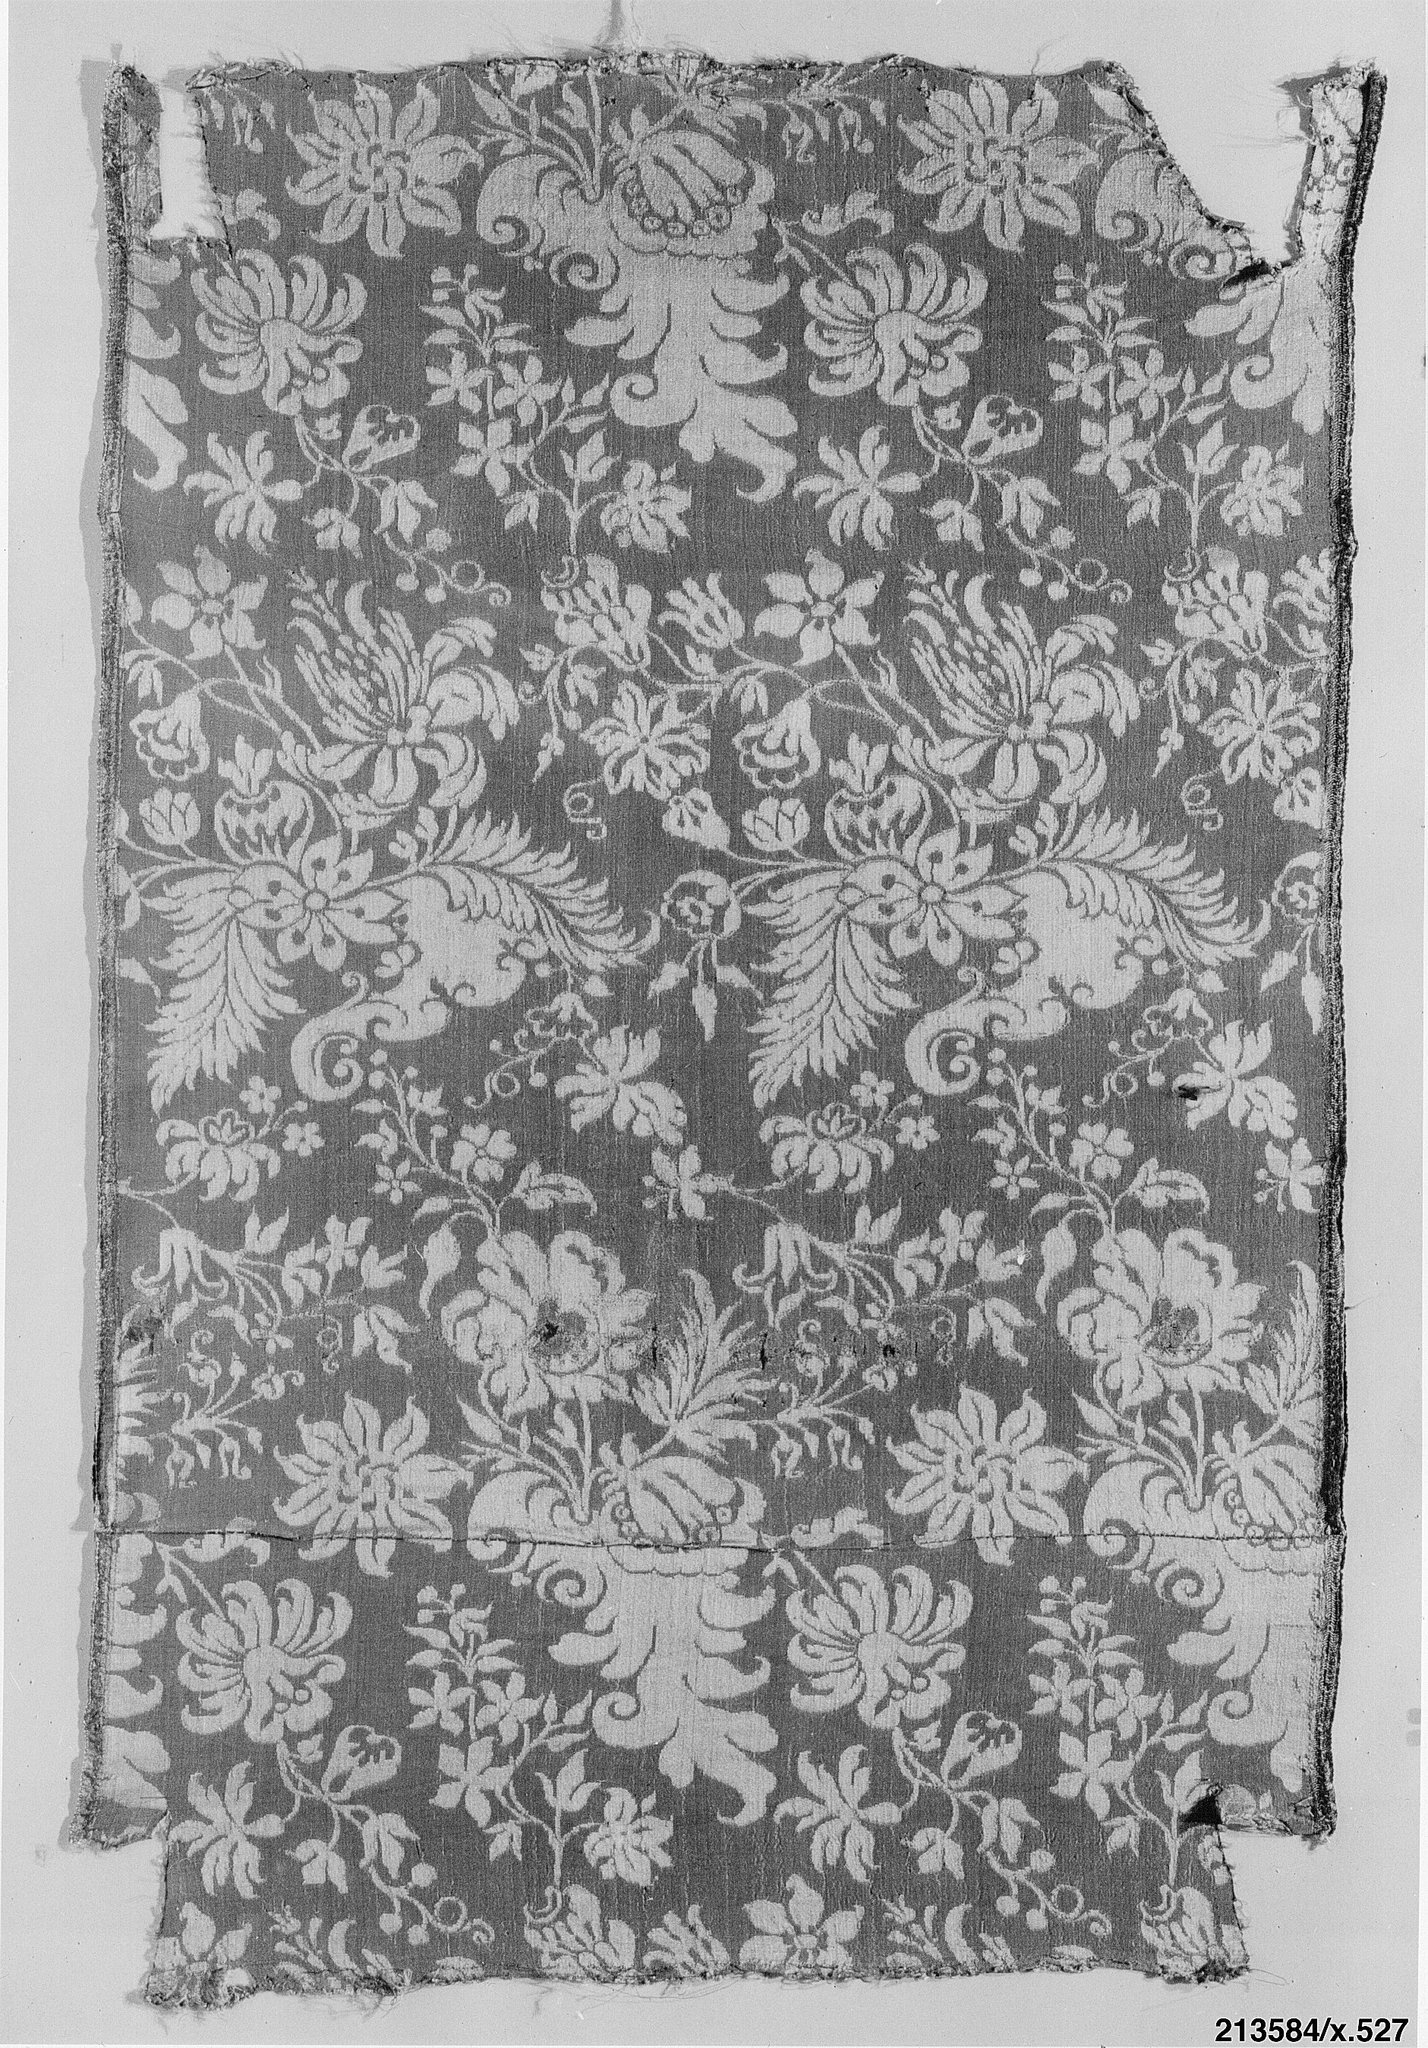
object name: piece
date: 1701-1800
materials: silk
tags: flowers,leaves